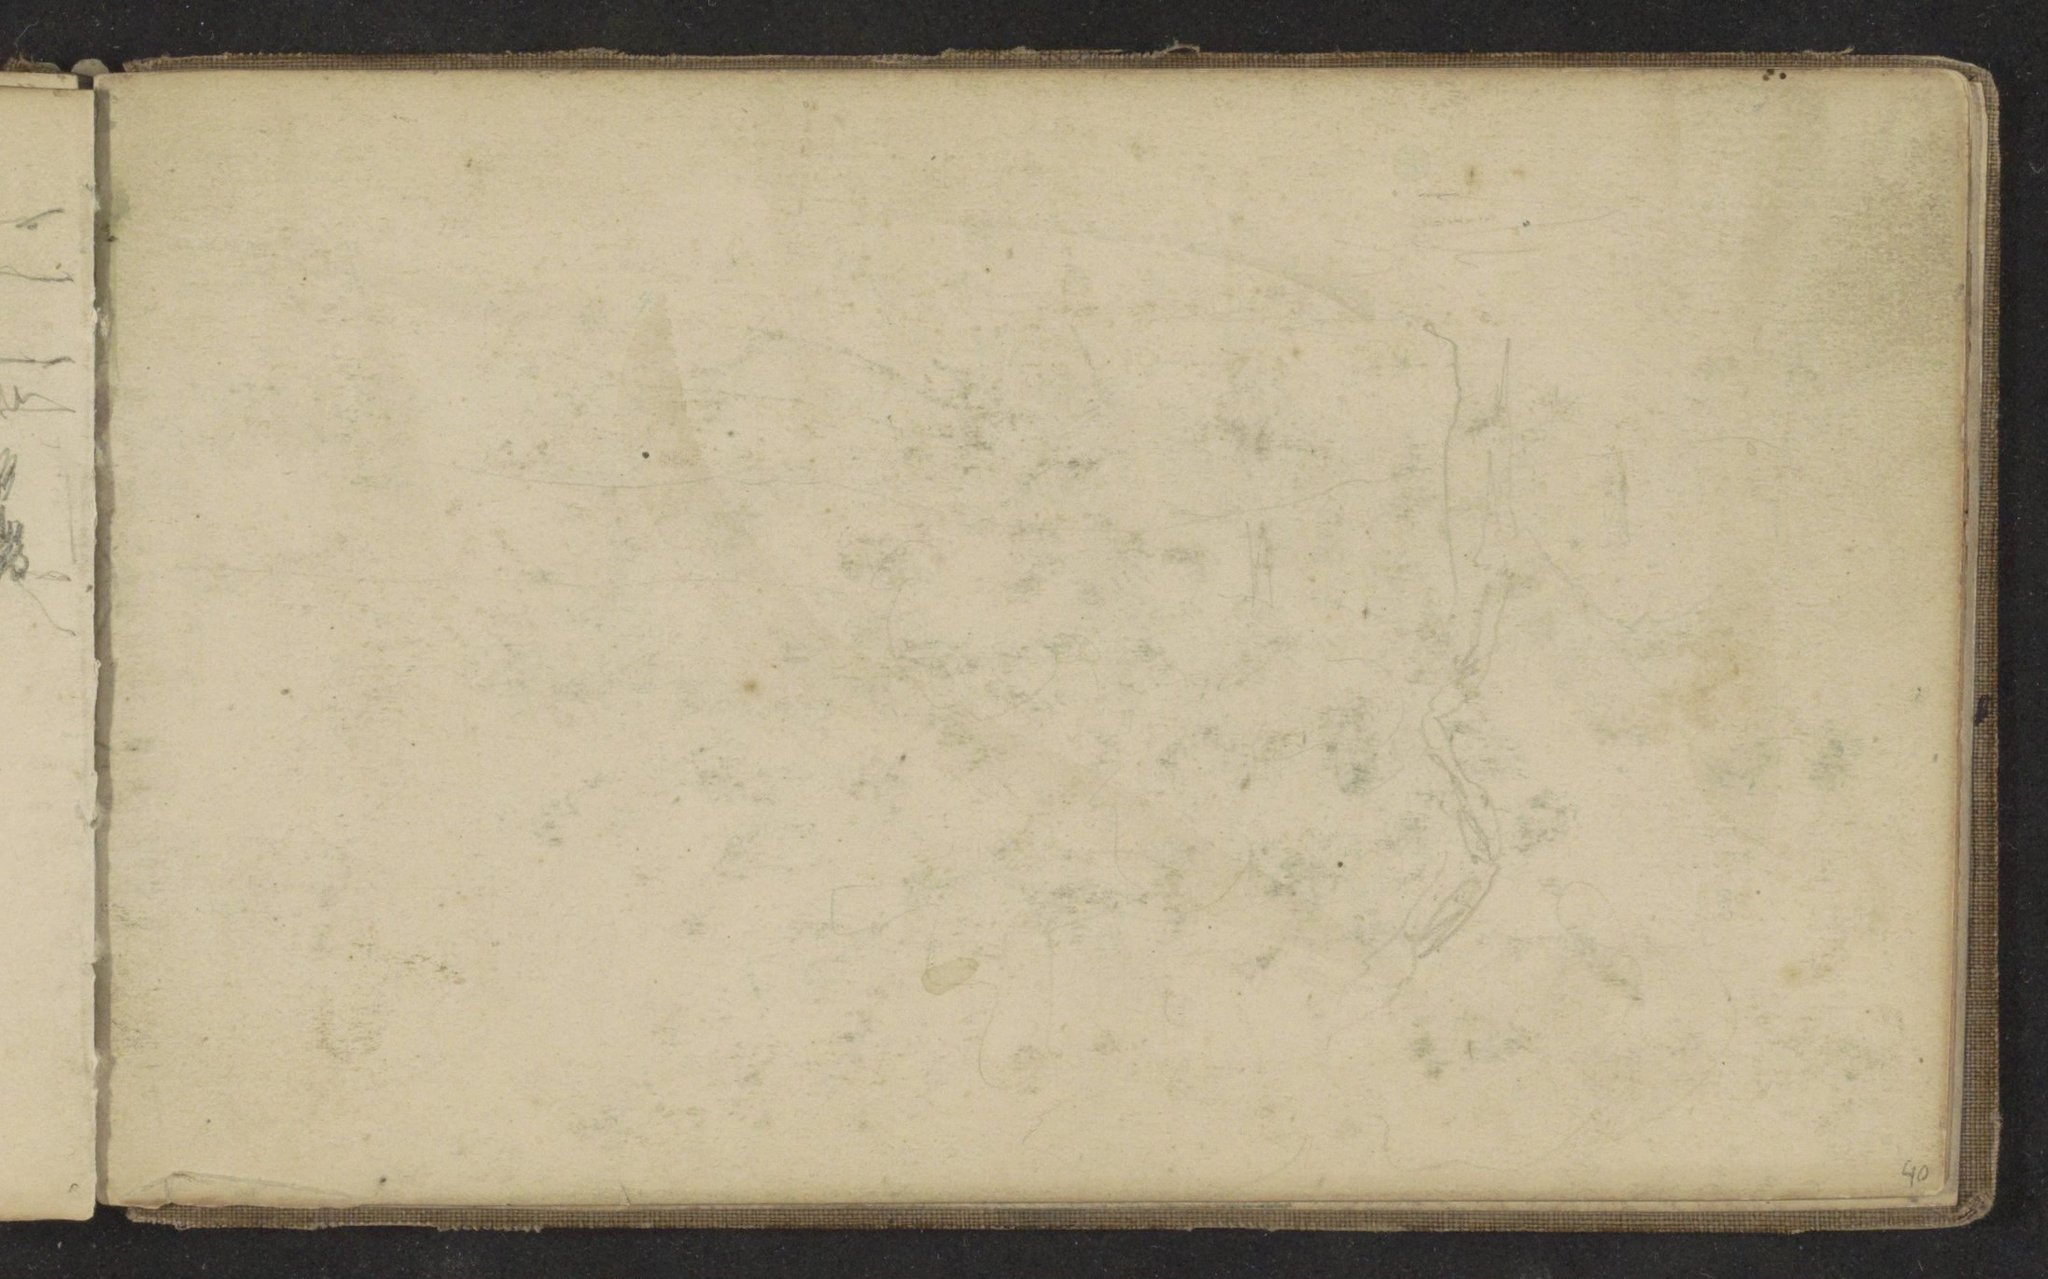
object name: sketchbook leaf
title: Studie, mogelijk een landschap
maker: johan hendrik weissenbruch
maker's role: draughtsman, painter, print maker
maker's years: 1824-1903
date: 1834-1903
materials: paper, pencil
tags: landscapes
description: Blad 40 recto uit een schetsboek met 43 bladen.